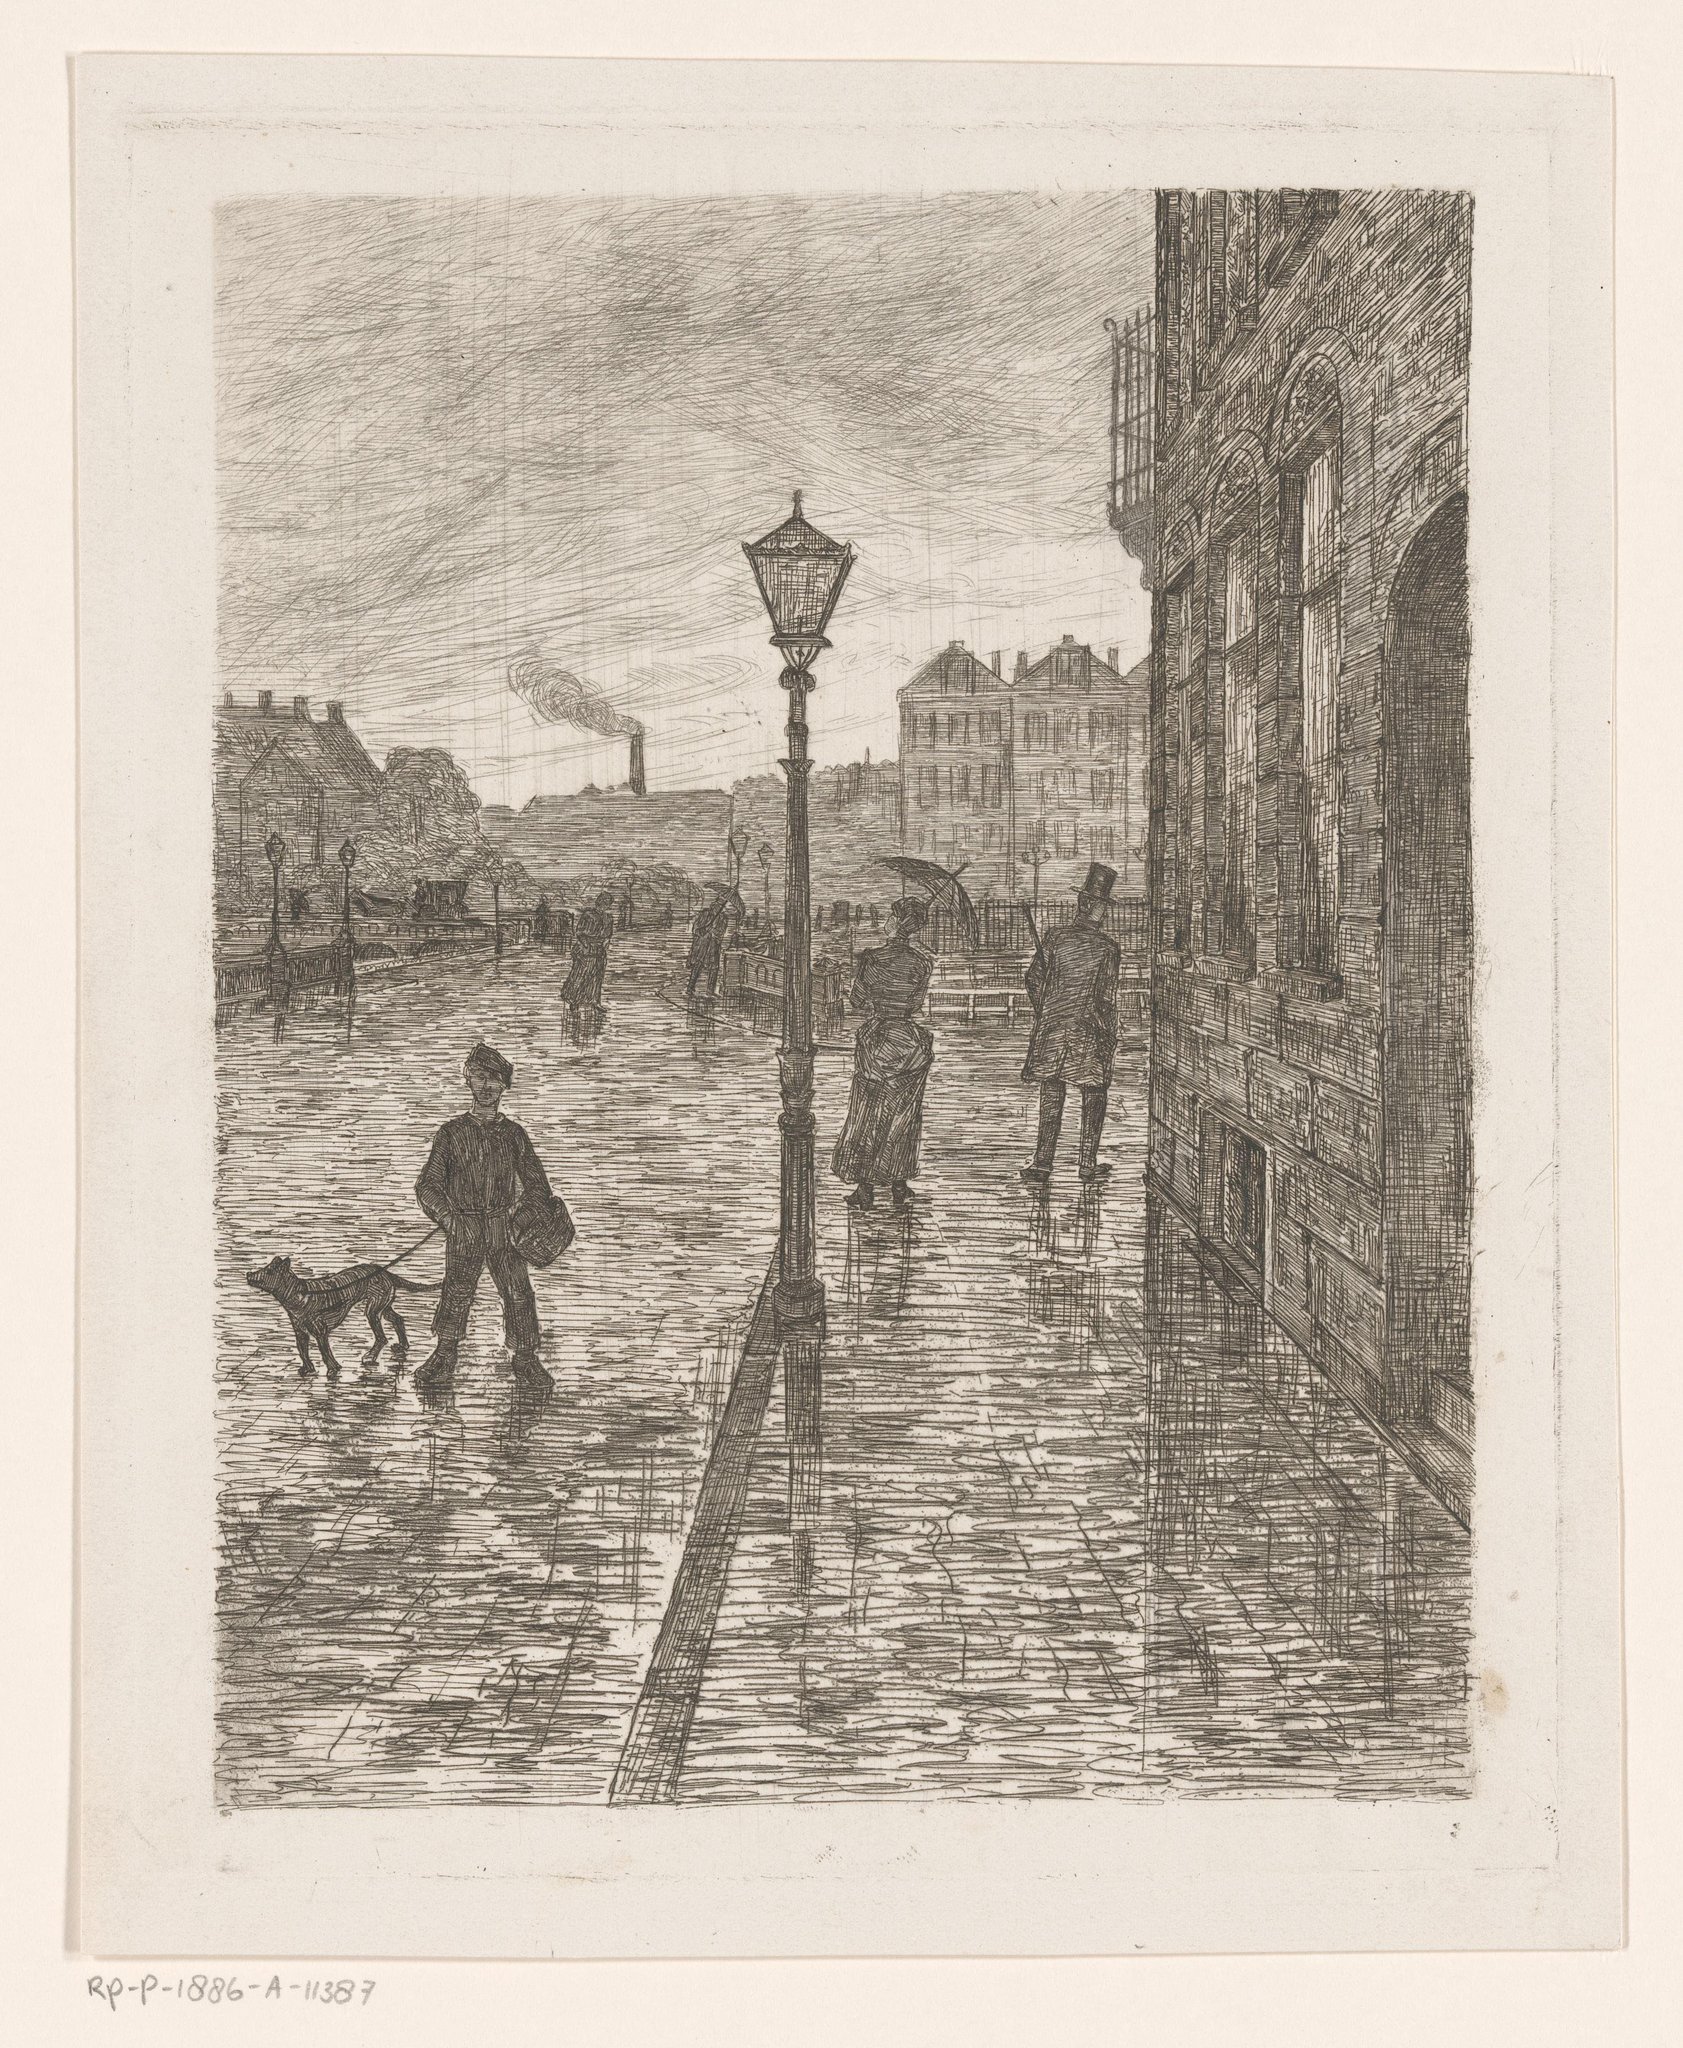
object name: print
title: Stadsgezicht bij regen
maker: egbert rubertus derk schaap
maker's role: draughtsman, painter, print maker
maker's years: 1862-1939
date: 1877-1886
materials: paper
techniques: etching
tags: city-view, and landscape with man-made constructions, city dwellers, dog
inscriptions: collector's mark: Lugt 2228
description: Links op de voorgrond loopt een jongen met een hond. Rechts loopt een man met een hoed en links daarvan een vrouw met een paraplu.